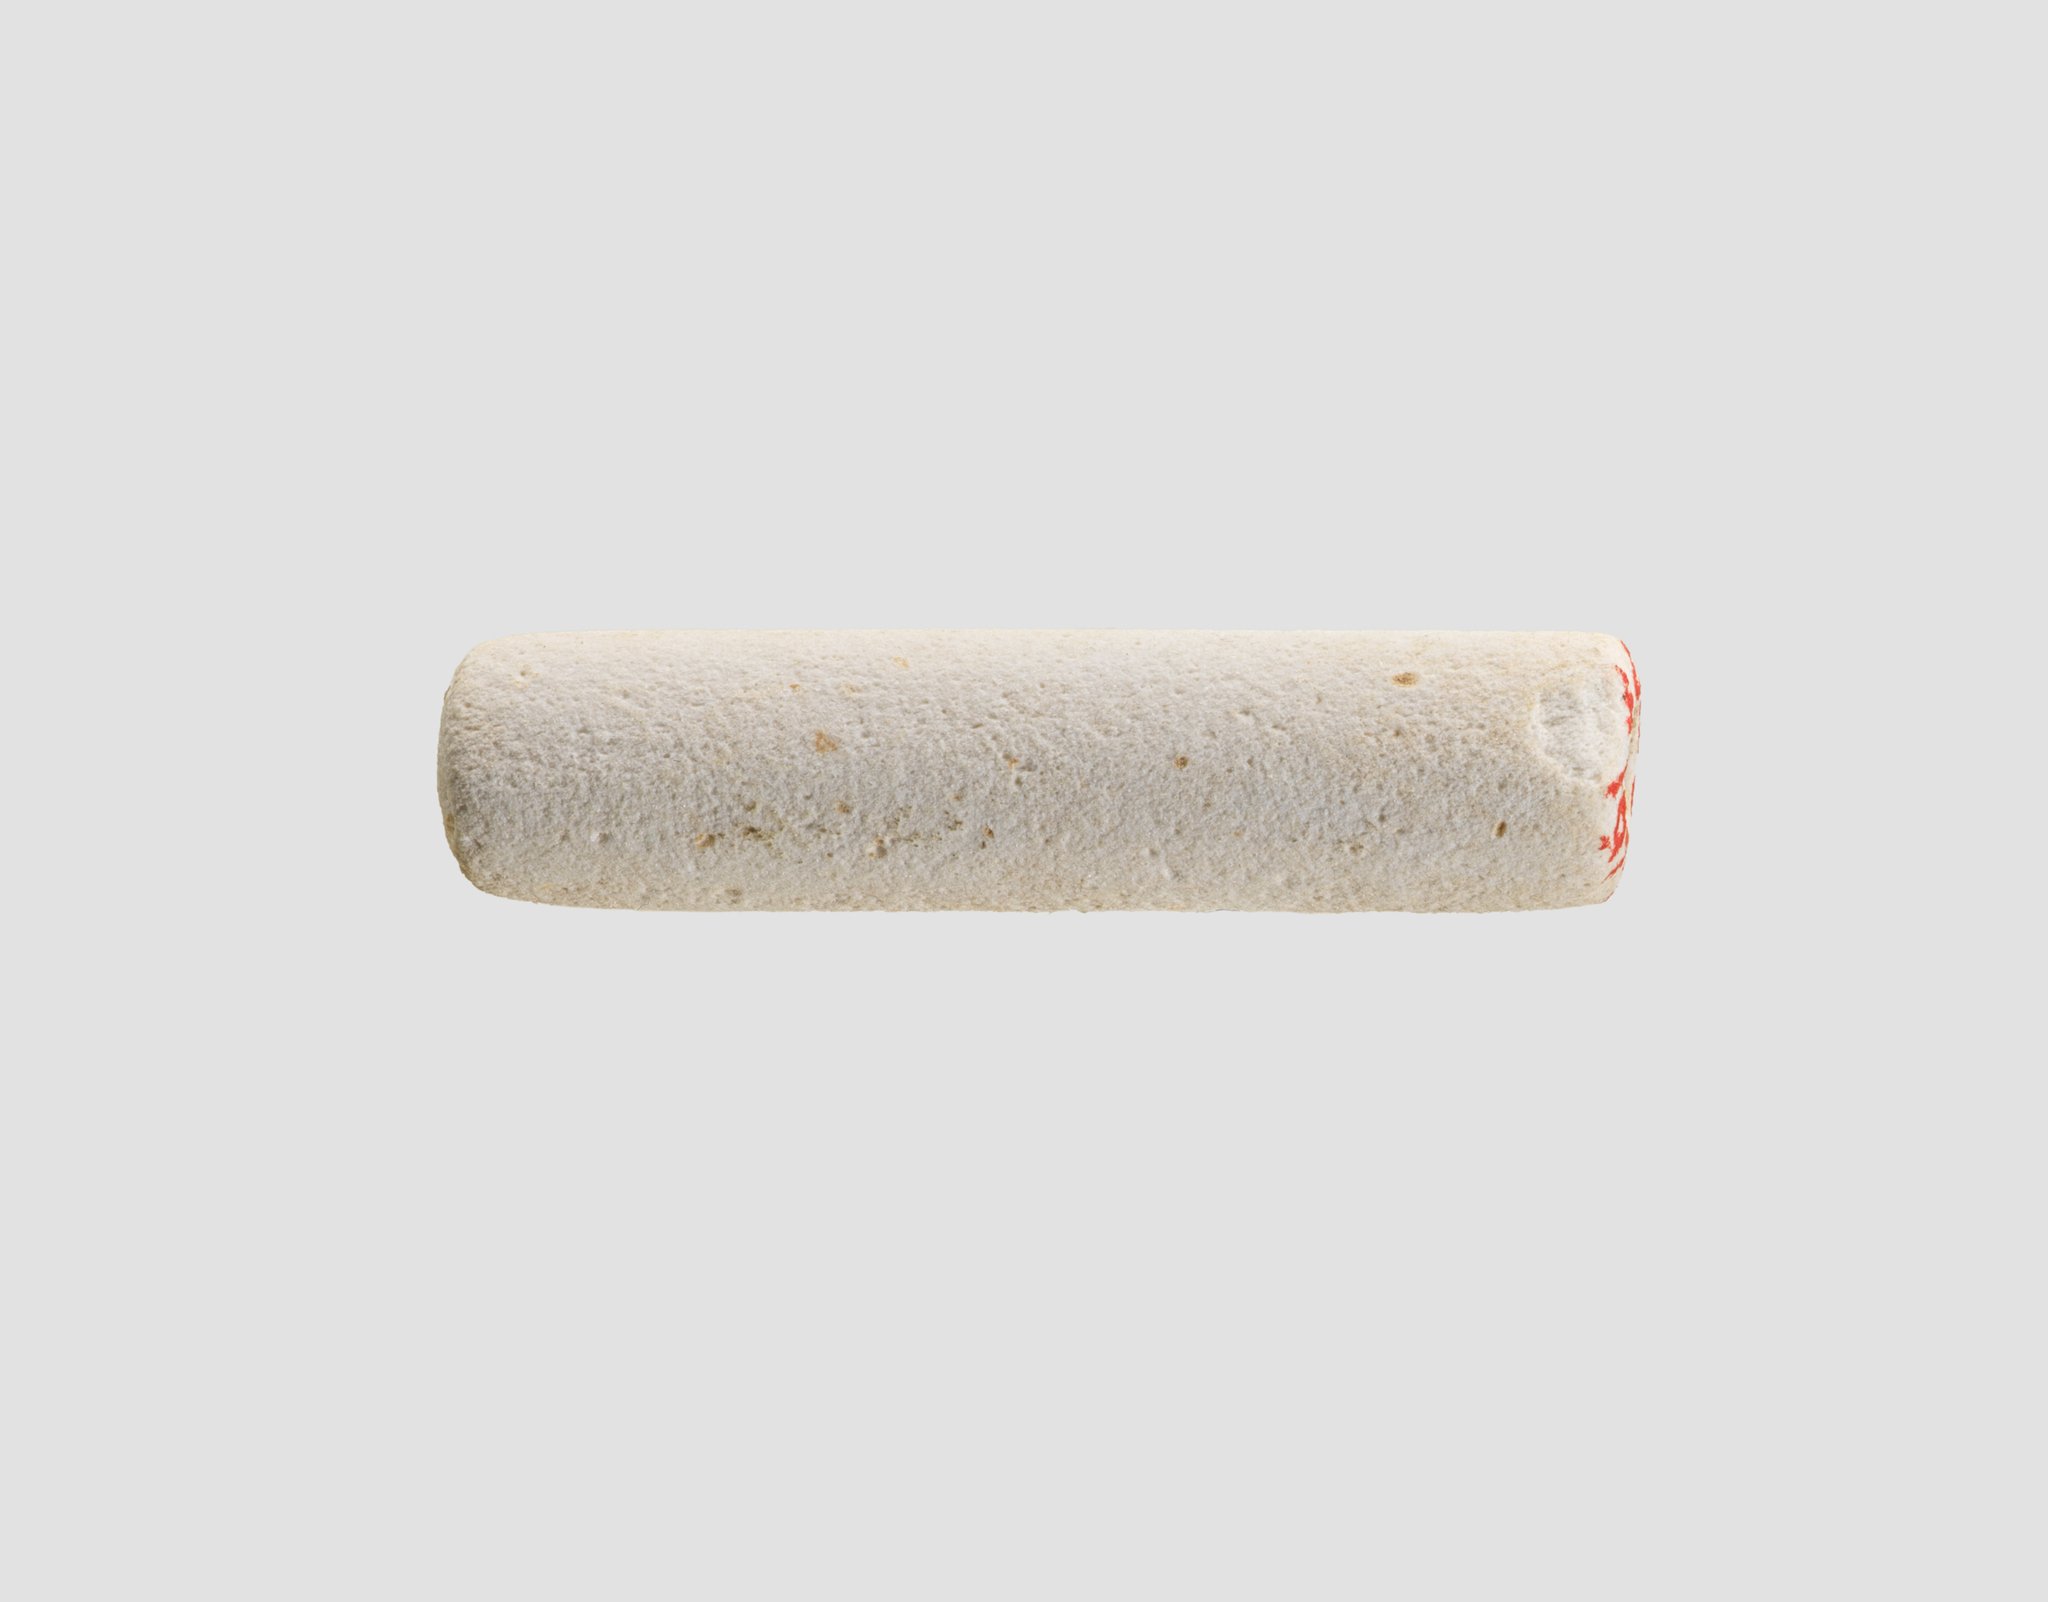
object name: ornament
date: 2333-2001 BCE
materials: faience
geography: mesopotamia